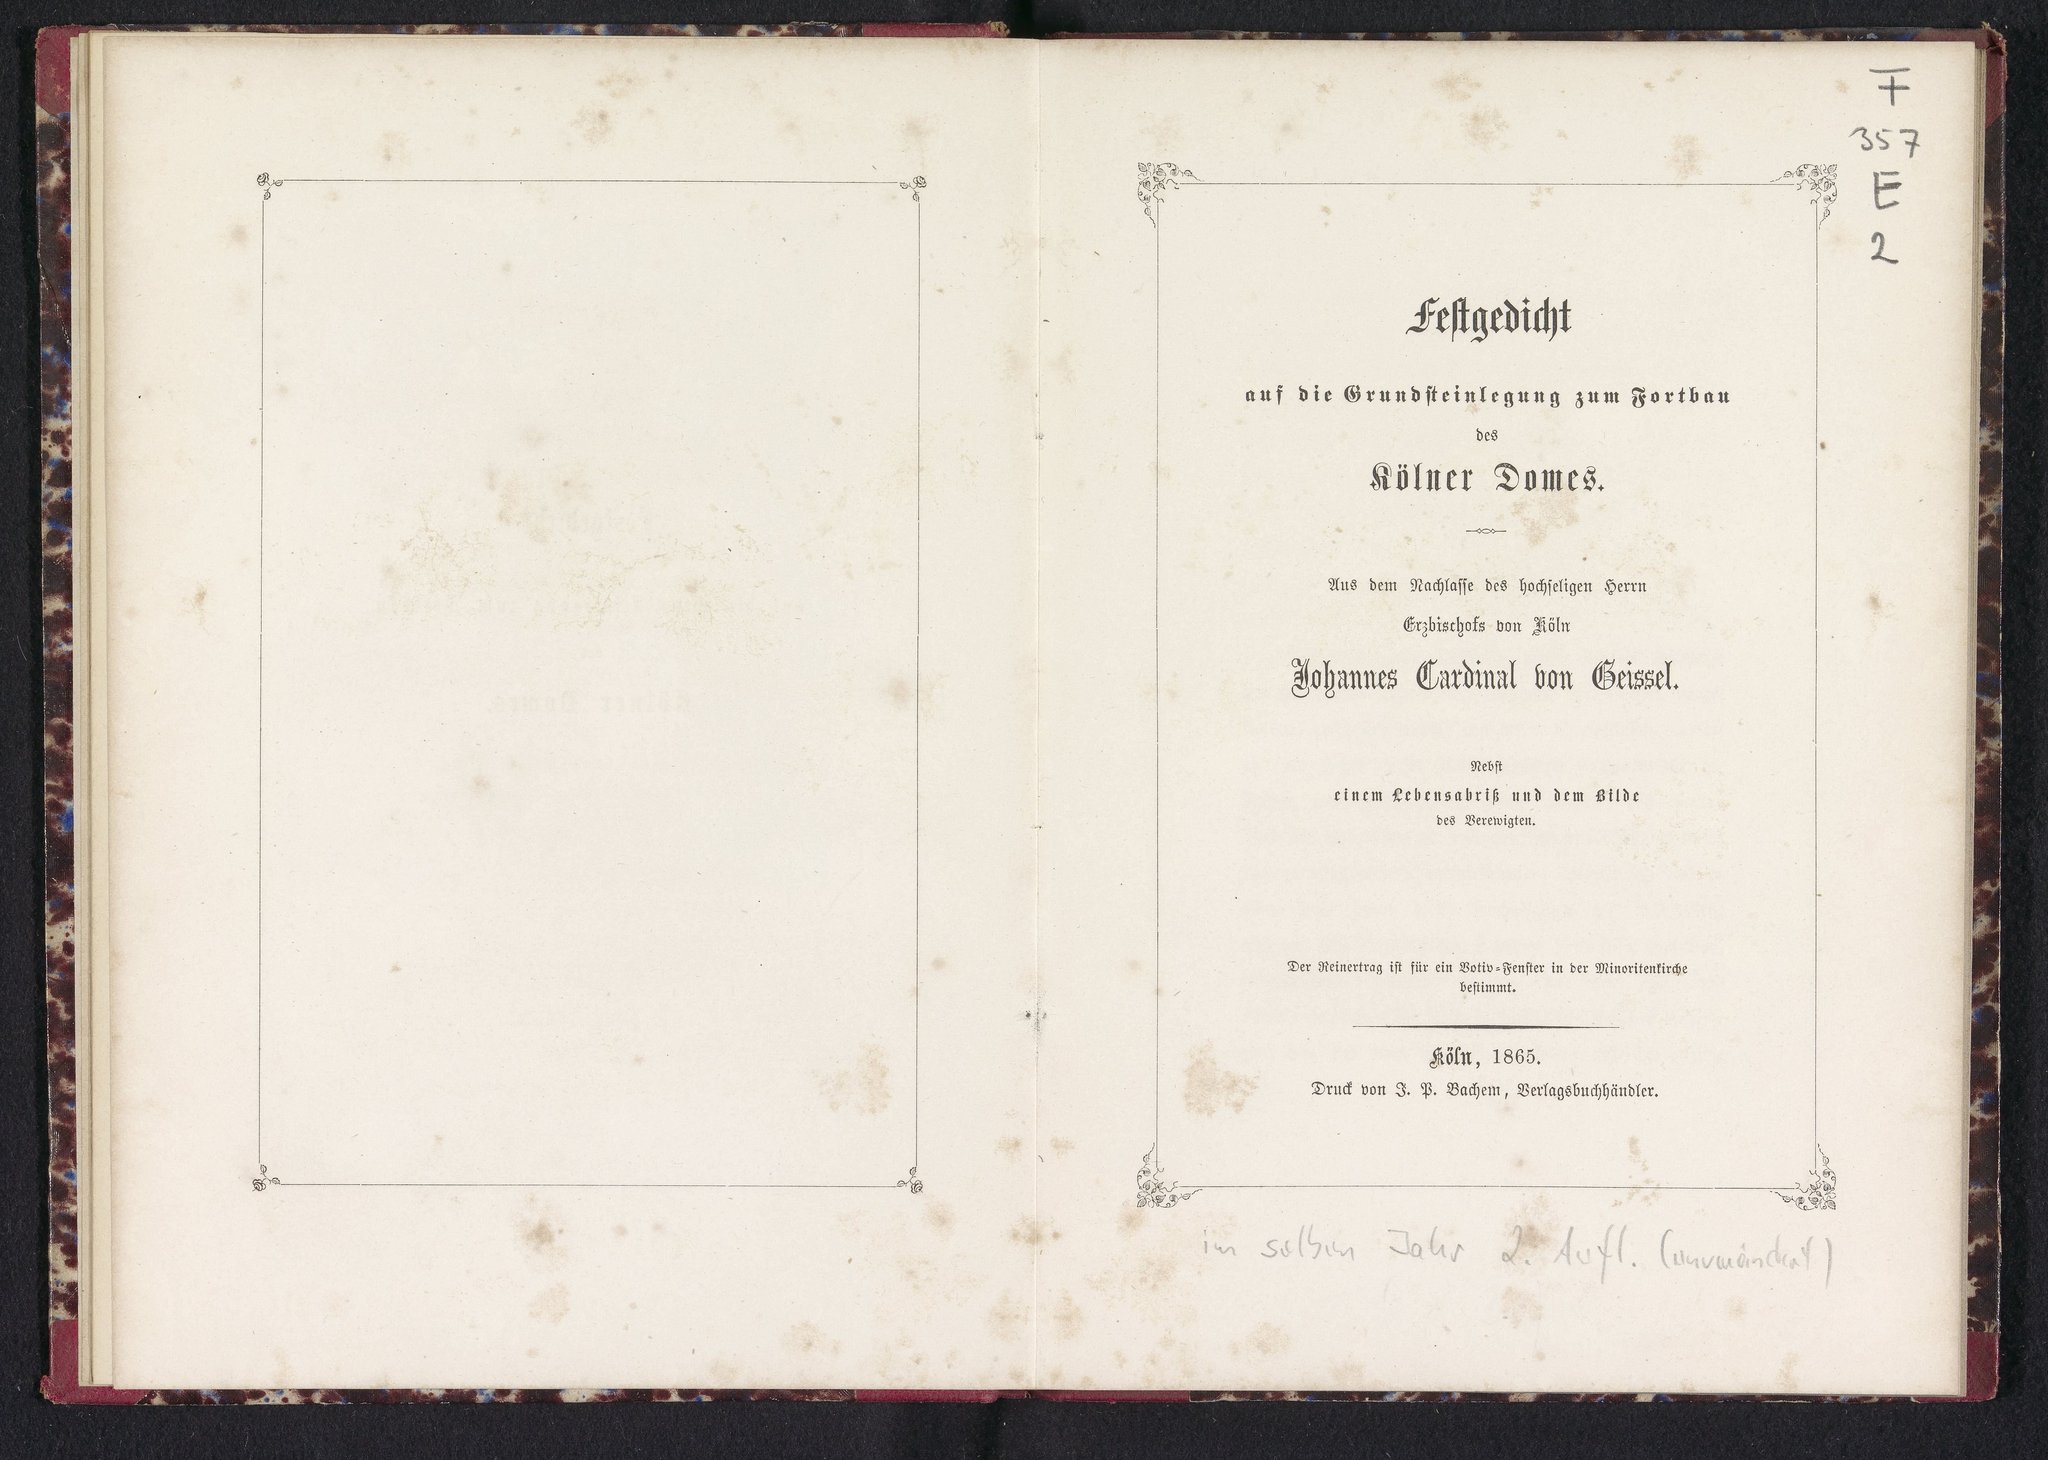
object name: book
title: Festgedicht auf die Grundsteinlegung zum Fortbau des Kölner Domes : aus dem nachlass des hochseligen Herrn, Erzbisschofs von Köln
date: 1865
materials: cardboard, leather, paper, photographic support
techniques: marbled paper, albumen print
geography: cologne